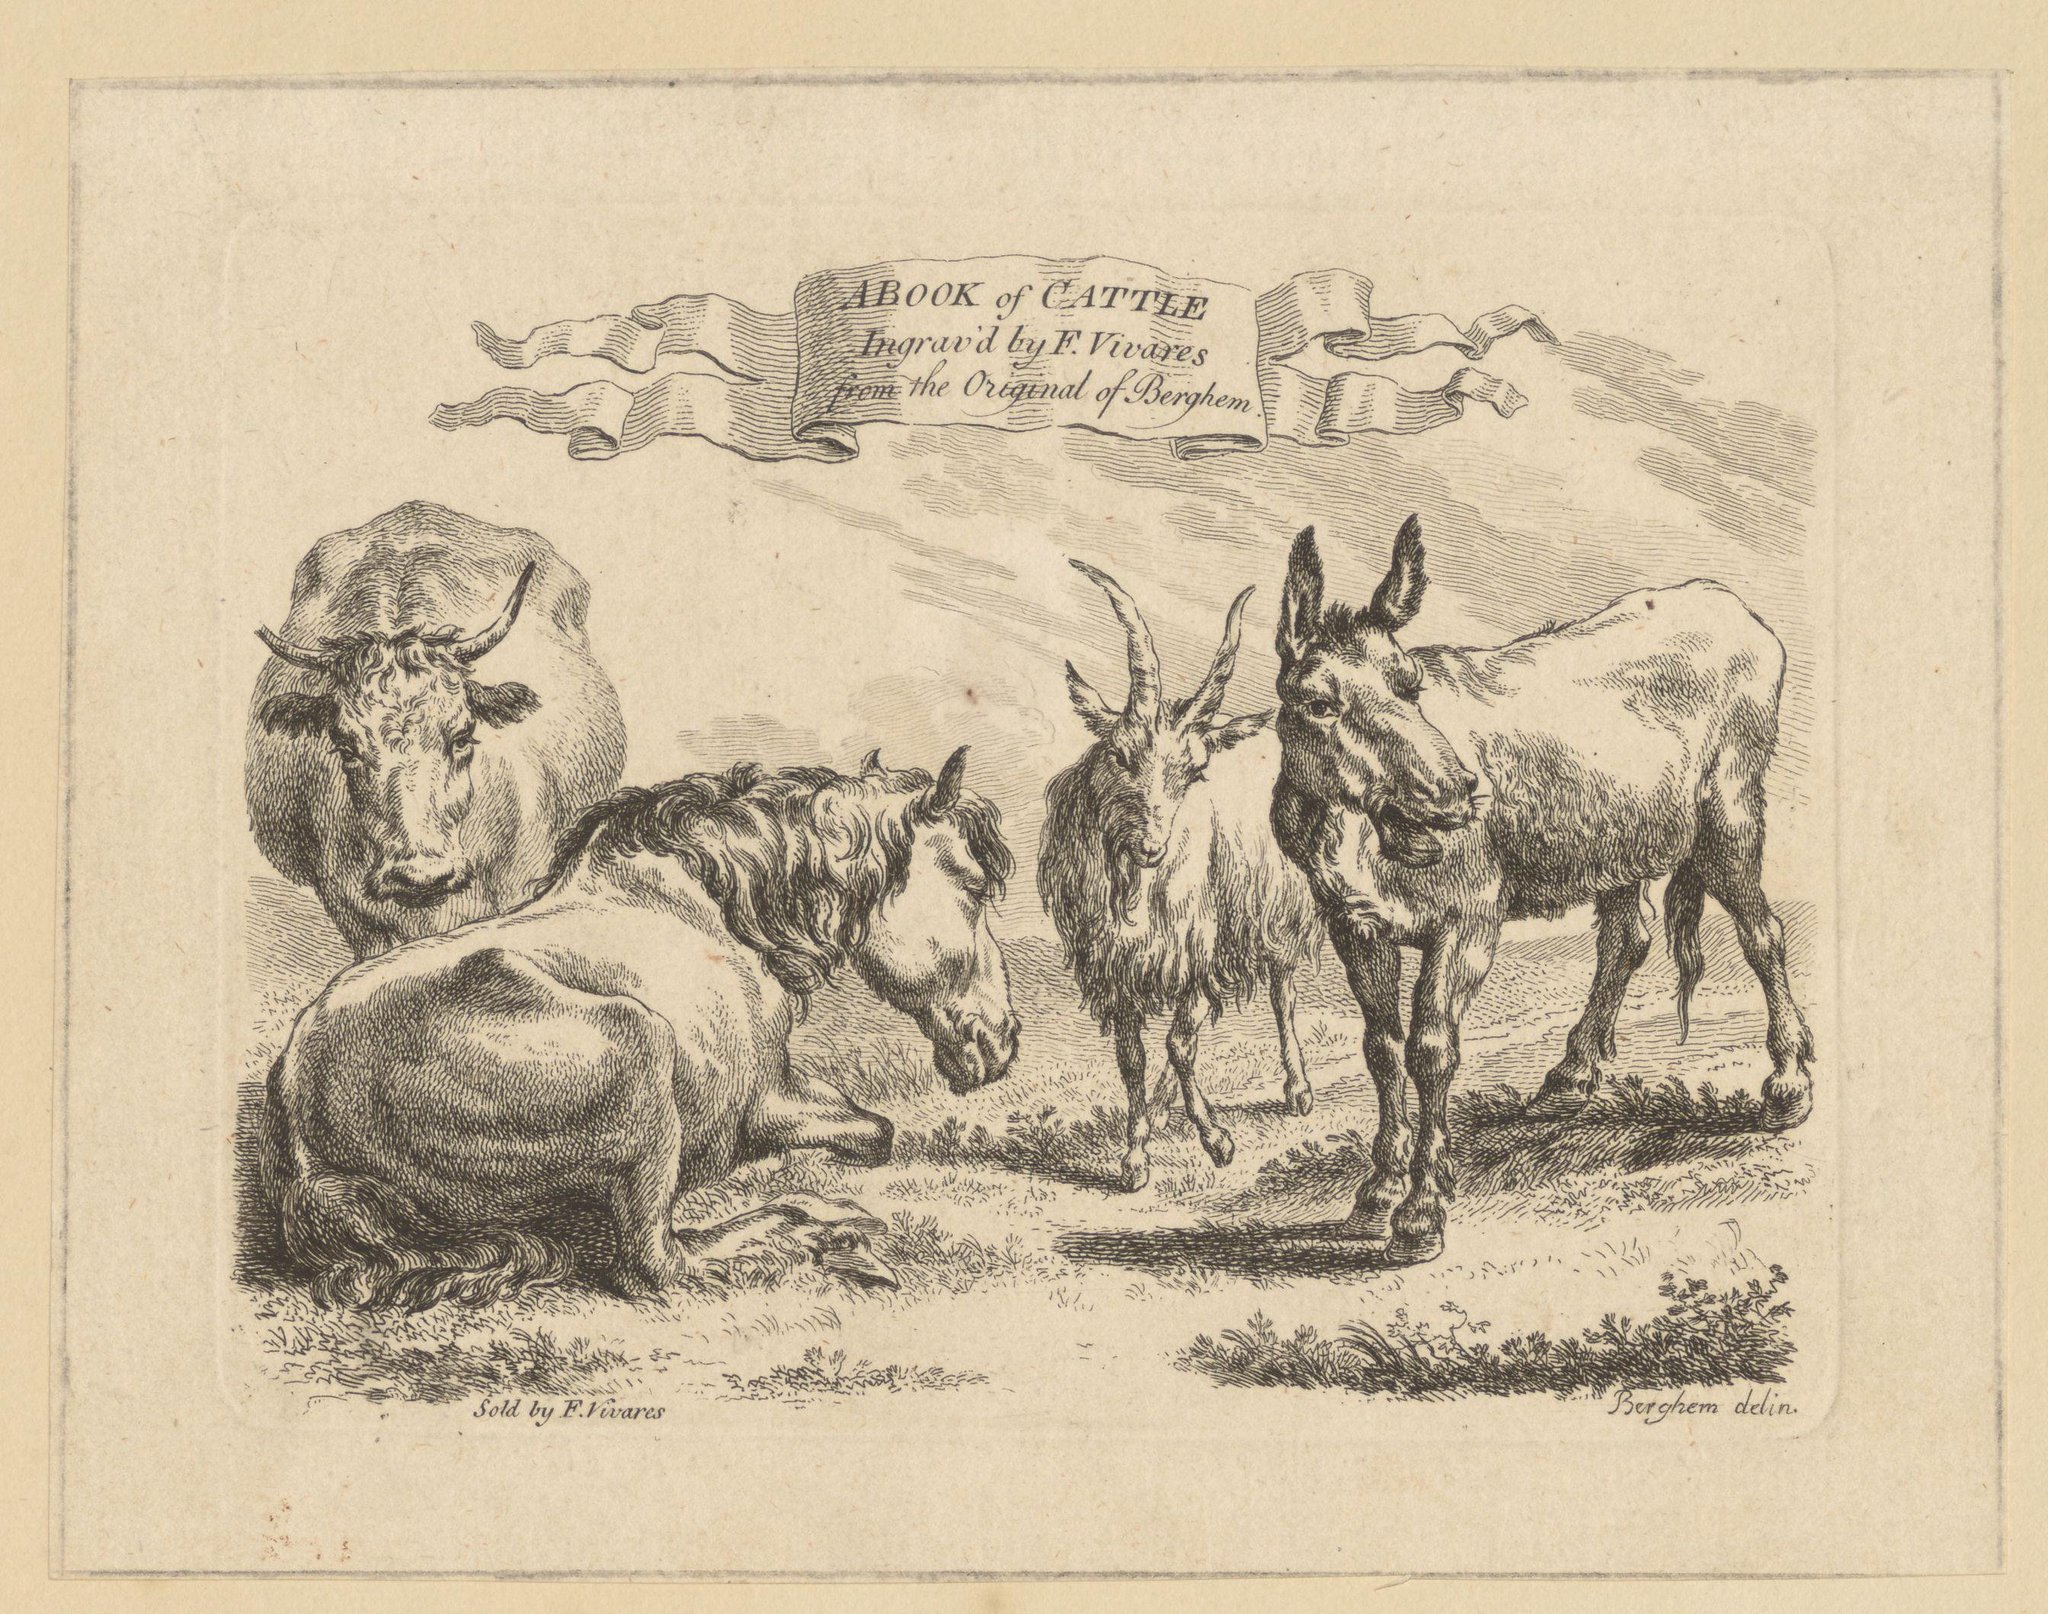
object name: titelprent, frontispice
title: Ezel, os, geit en een paard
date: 1719-1780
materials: paper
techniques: etching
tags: cattle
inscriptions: collector's mark: Lugt 240